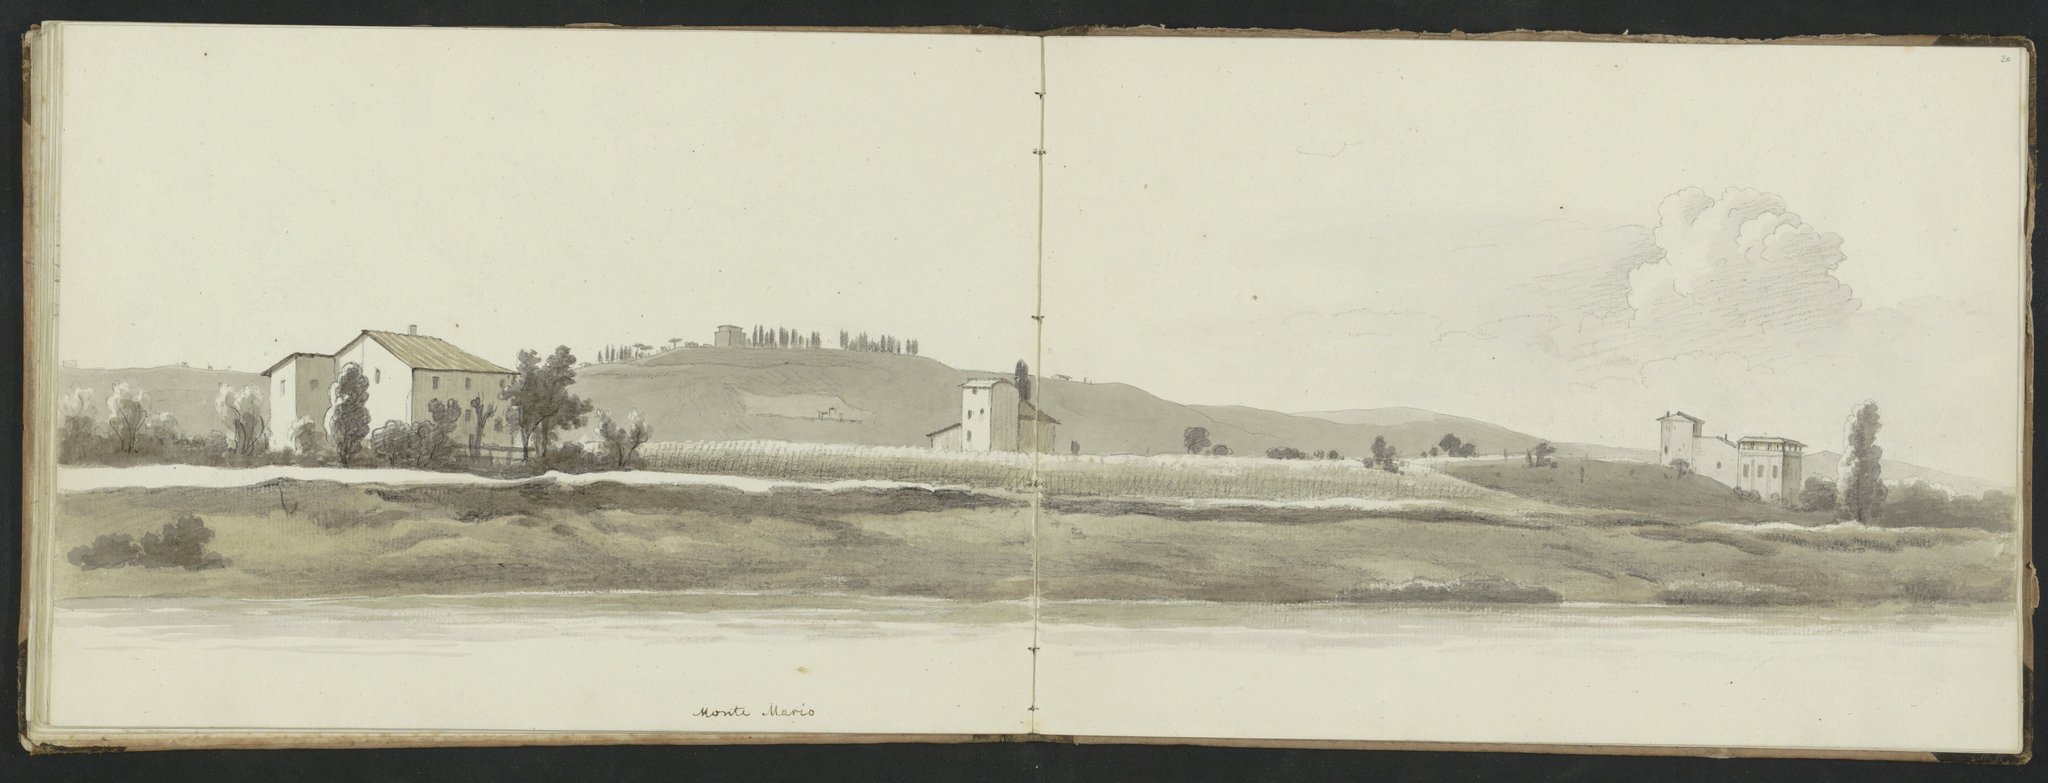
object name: sketchbook leaf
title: Gezicht op Monte Mario te Rome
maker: abraham teerlink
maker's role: draughtsman, painter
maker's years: 1776-1857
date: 1808-1857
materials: ink, paper, pencil, watercolor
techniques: brush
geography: rome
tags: city-view, and landscape with man-made constructions, mountains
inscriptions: annotation: ‘Monte Mario’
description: Blad 19 verso en 20 recto uit een schetsboek met 28 bladen.